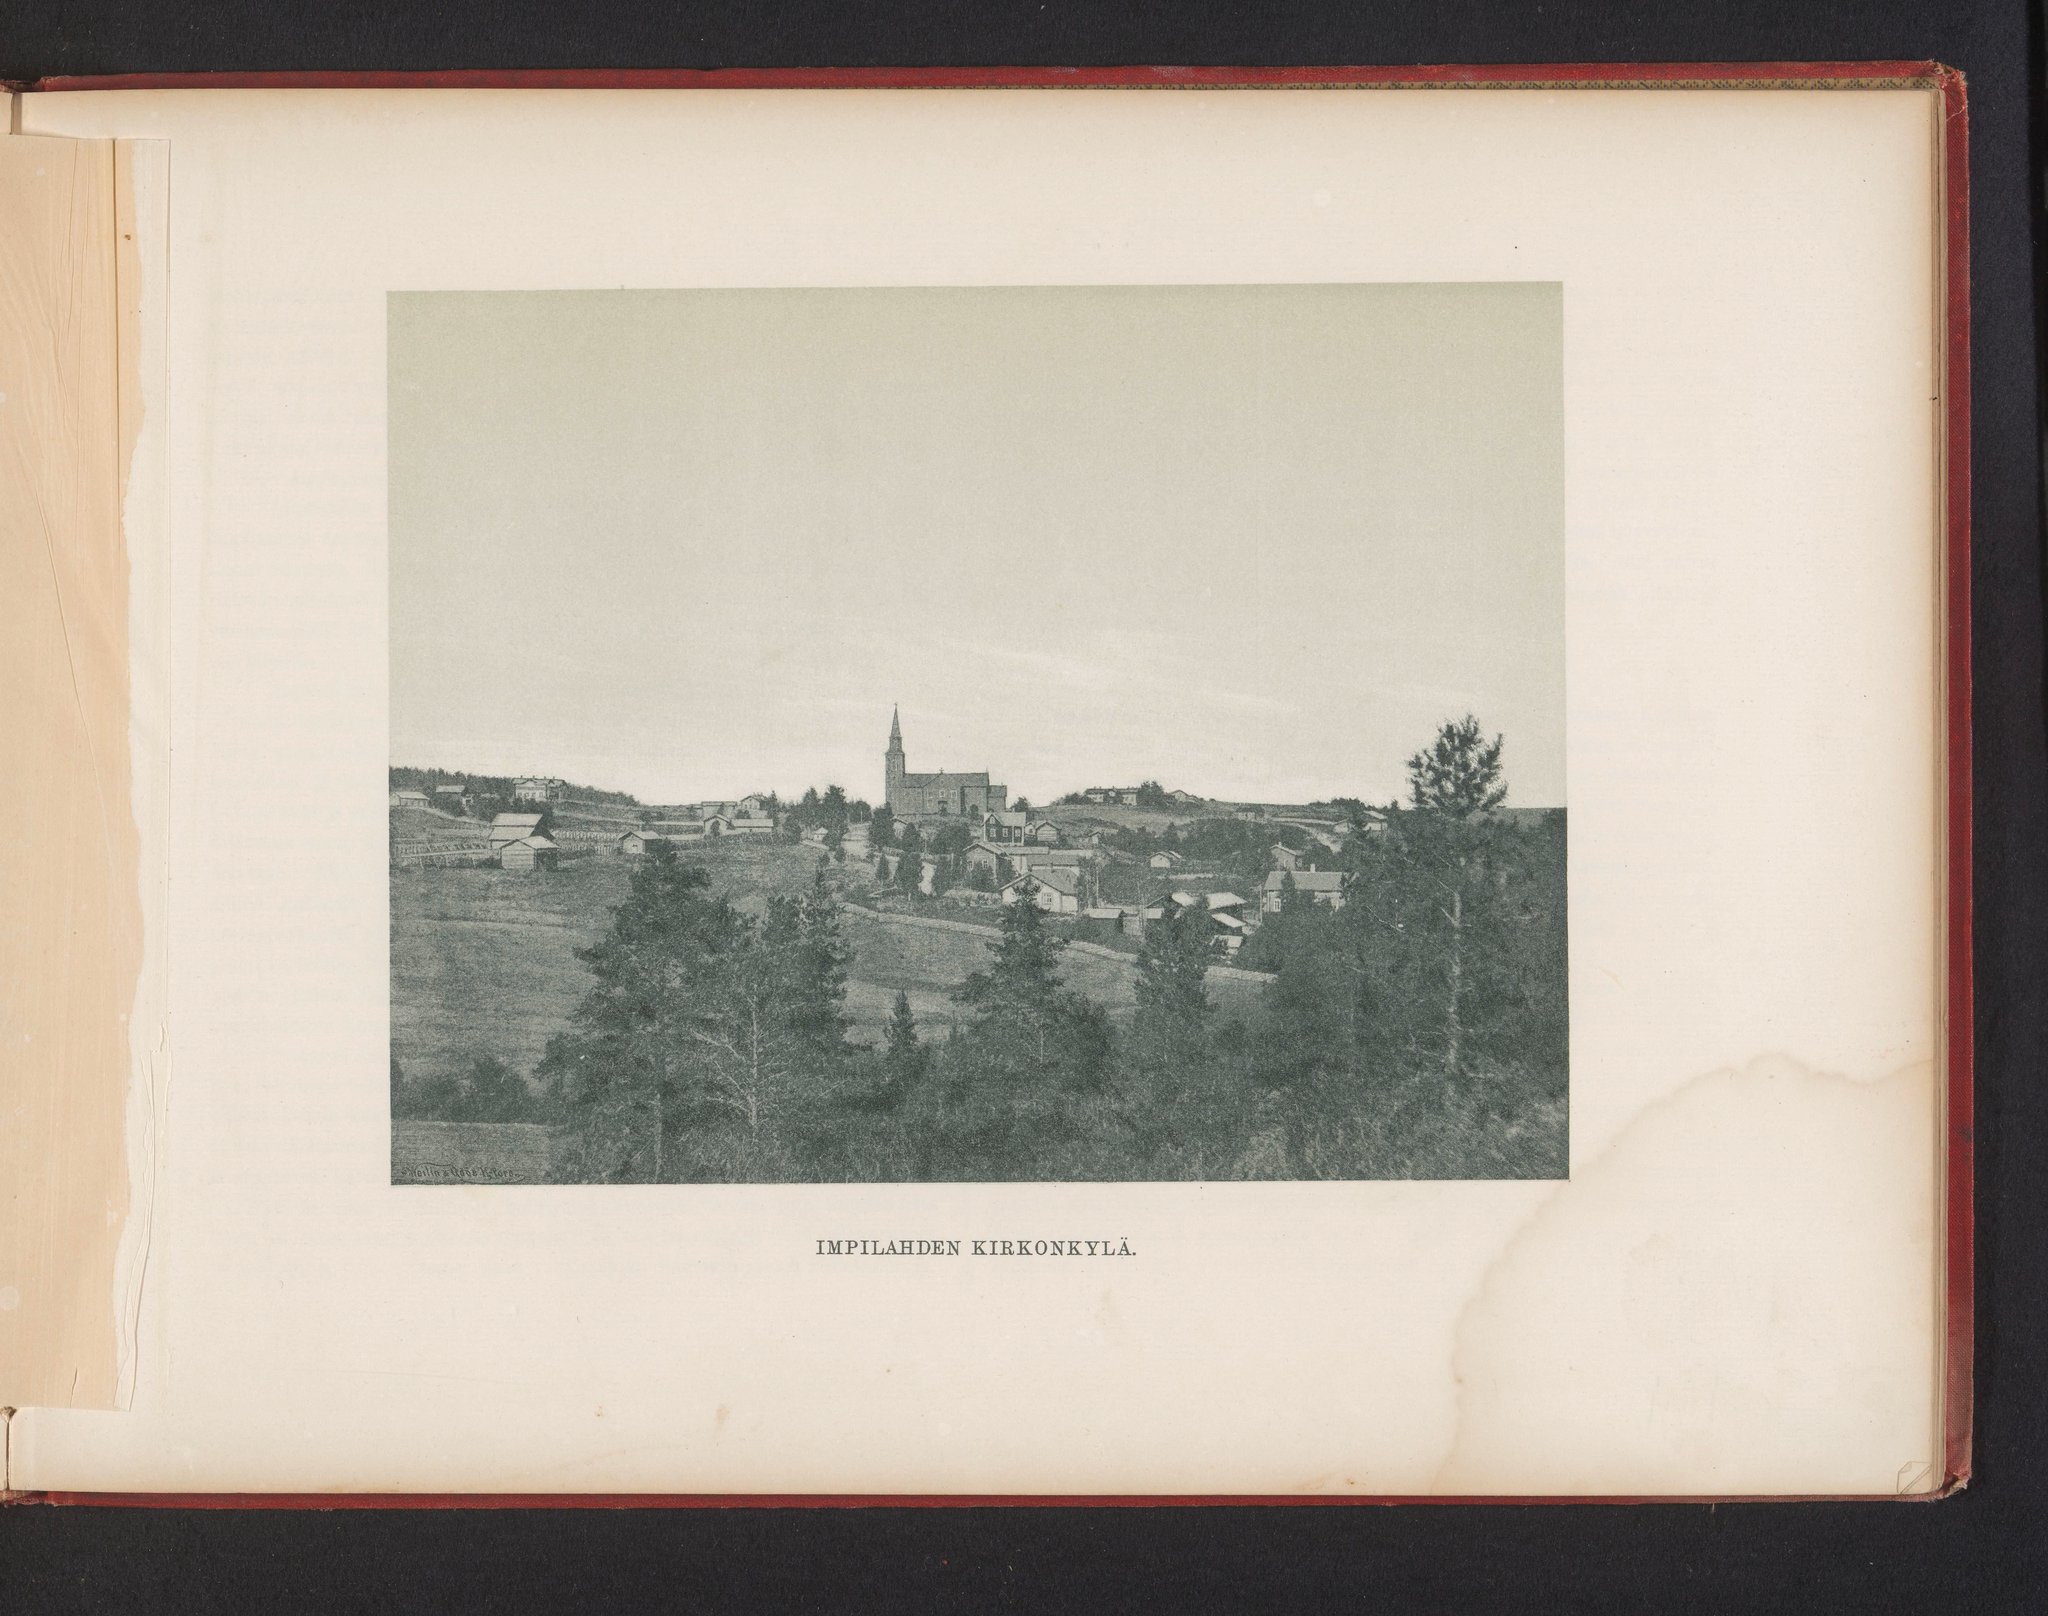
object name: photomechanical print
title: Gezicht op een dorp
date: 1888-1893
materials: paper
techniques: autotype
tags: city-view in general; 'veduta', church (exterior)